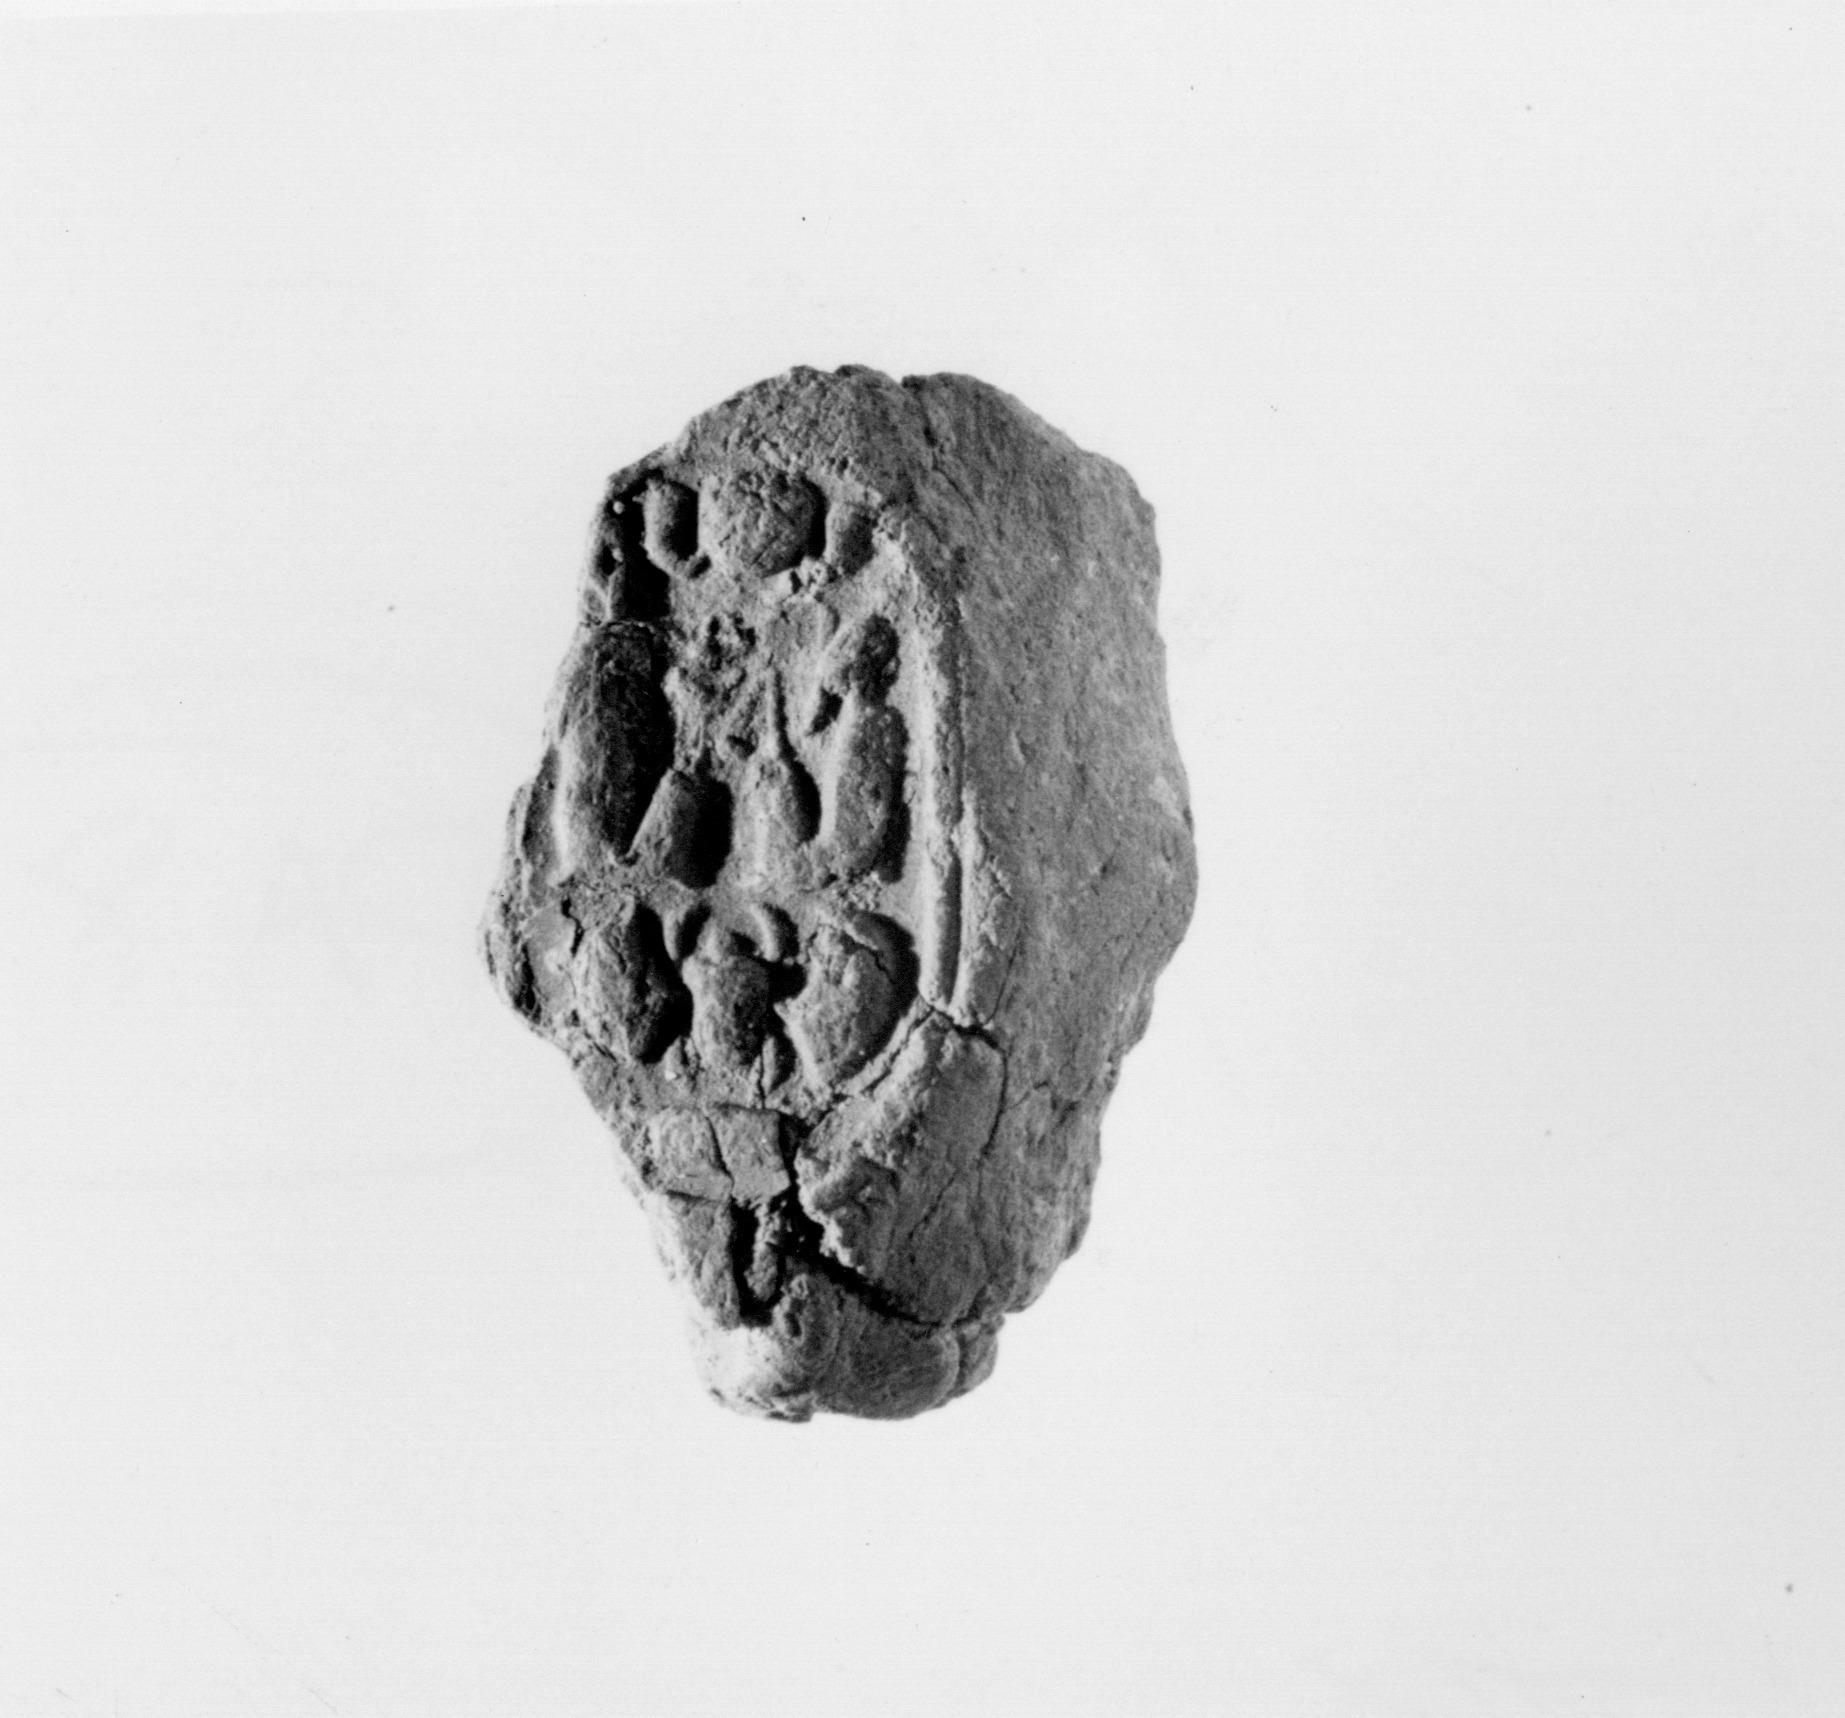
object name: sealing, nebmaatre, amenhotep iii,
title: Document Sealing With the Throne Name of Amenhotep III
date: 1390-1352 BCE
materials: mud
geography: egypt